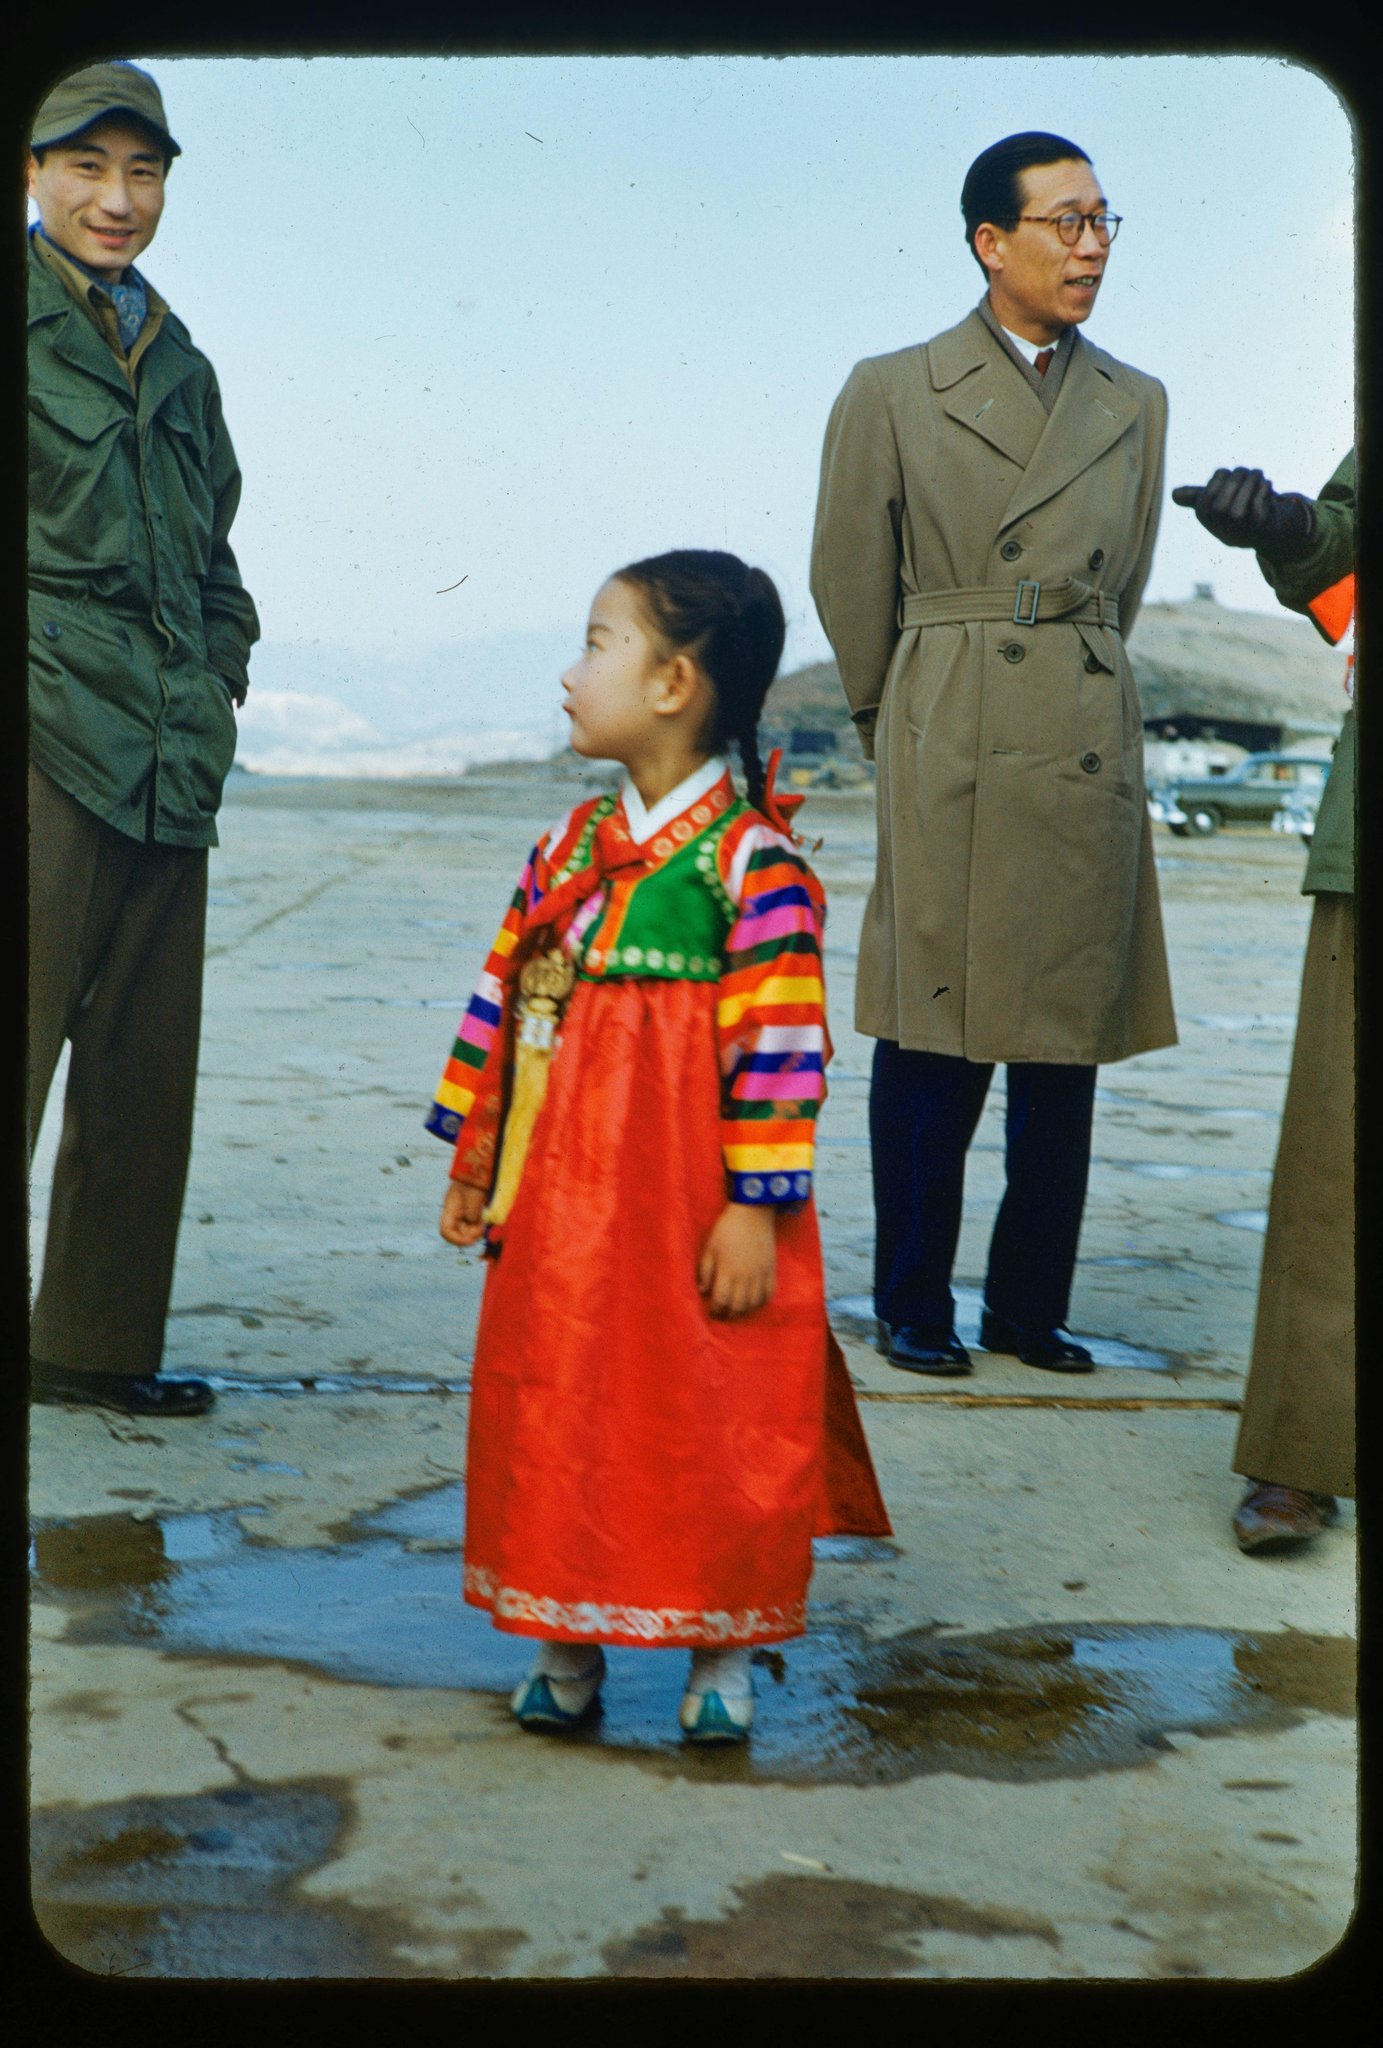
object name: color slide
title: Oorlog in Korea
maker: david ketel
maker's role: diplomaat, sinoloog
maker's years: 1913-2008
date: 1951-1953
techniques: slide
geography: korea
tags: united nations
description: Koreaans meisje in feest klederdracht. Links en rechts van haar een soldaat.